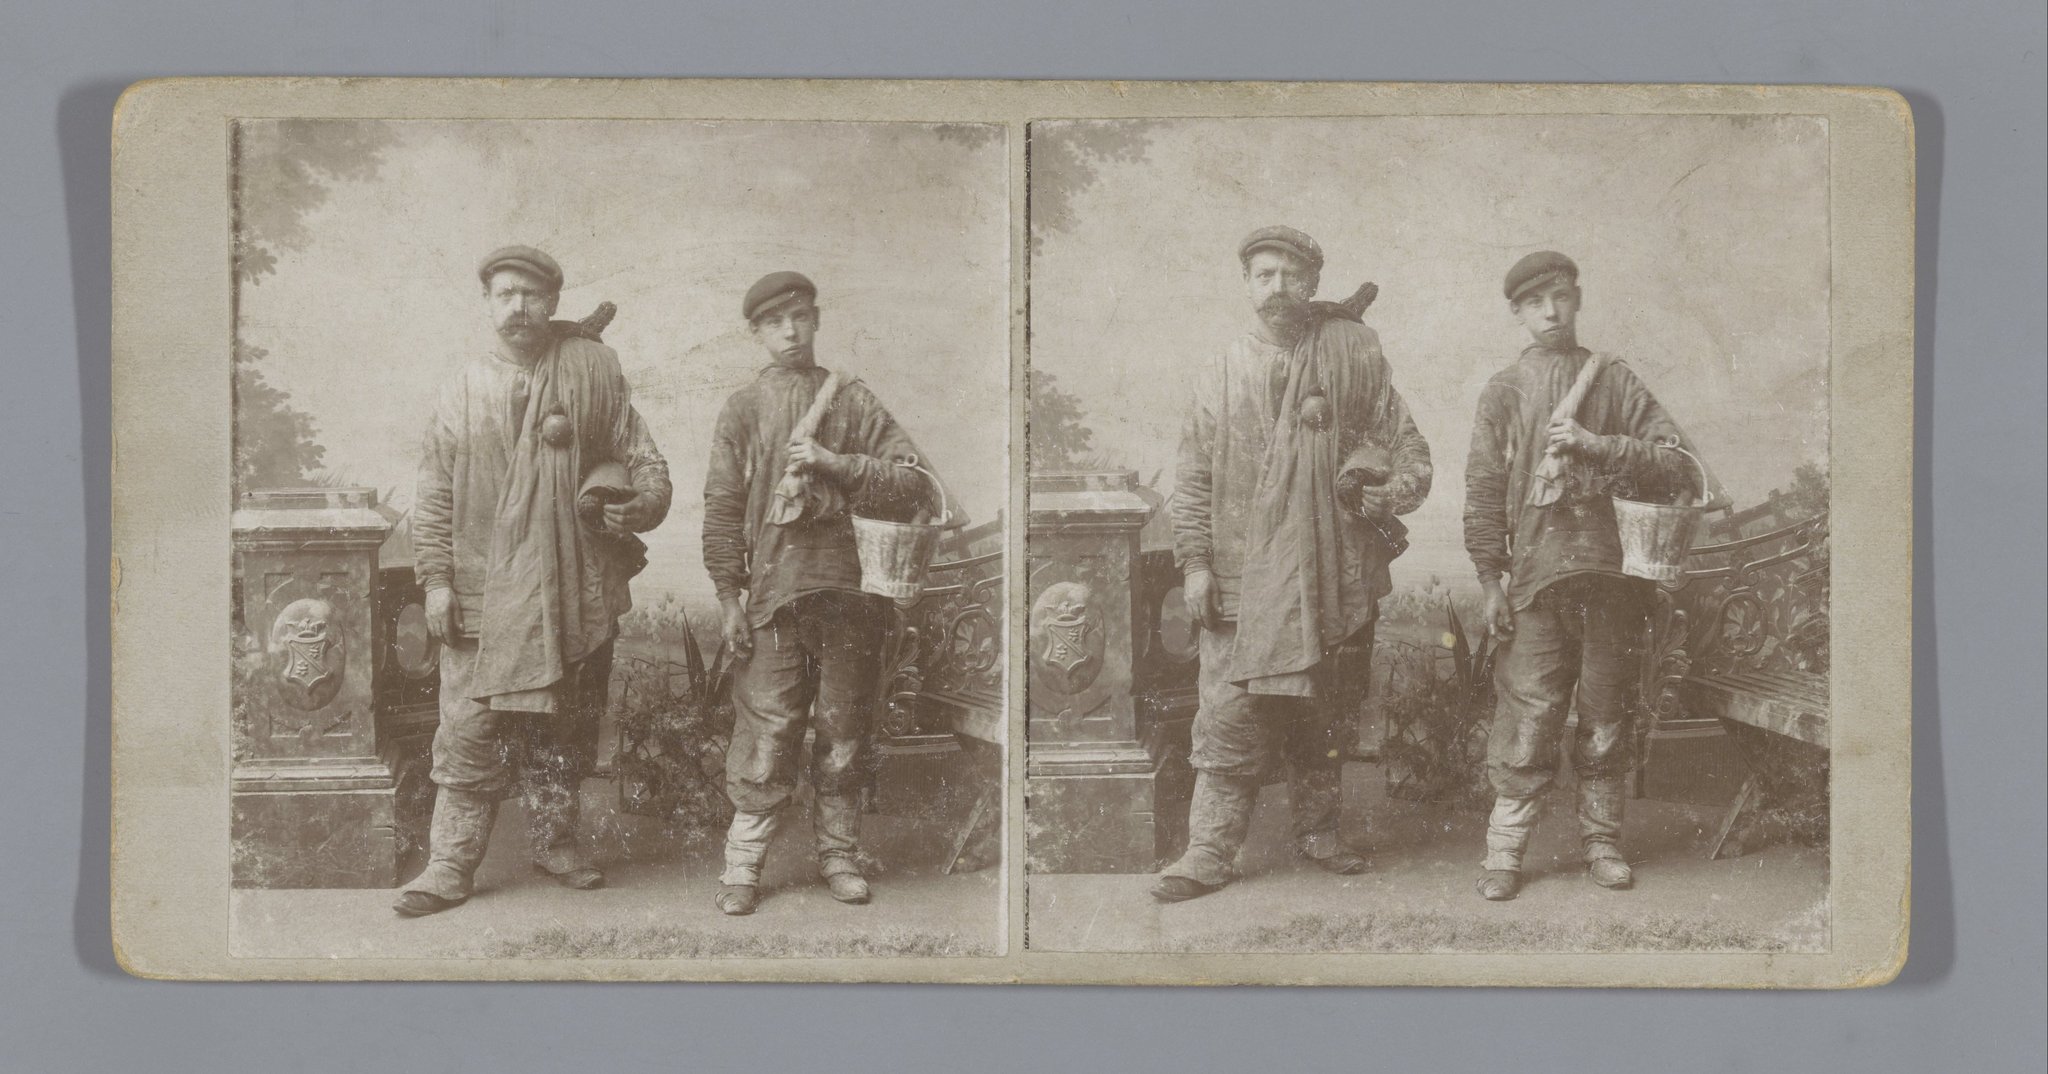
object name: stereograph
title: Portret van twee onbekende arbeiders met attributen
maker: Anonymous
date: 1850-1880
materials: cardboard, photographic support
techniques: collodion silver print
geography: europe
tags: studio requisites ~ photographer, farmers, europe